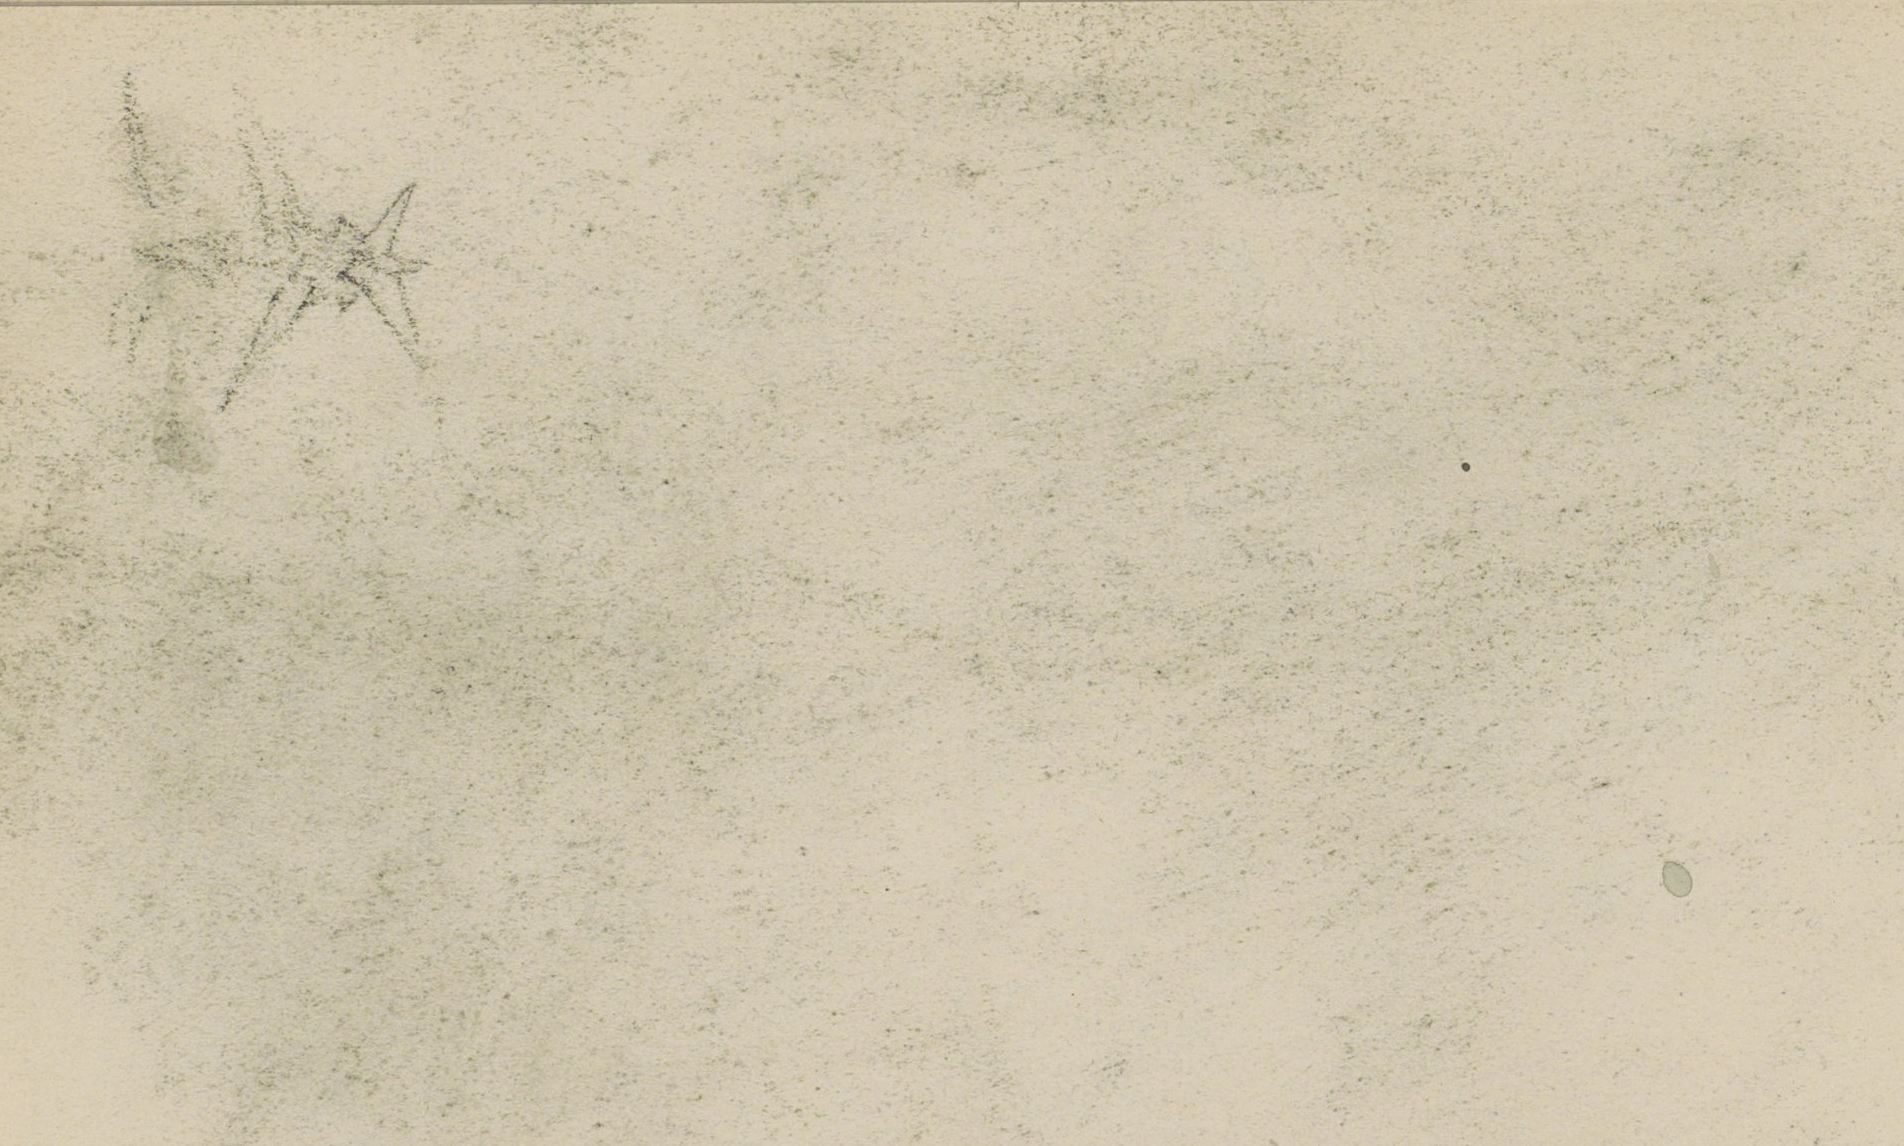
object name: sketchbook leaf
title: Studie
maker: johan antonie de jonge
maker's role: draughtsman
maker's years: 1864-1927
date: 1881-1927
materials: chalk, paper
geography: south holland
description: Studie. Blad 10 verso uit een schetsboek met 34 bladen.